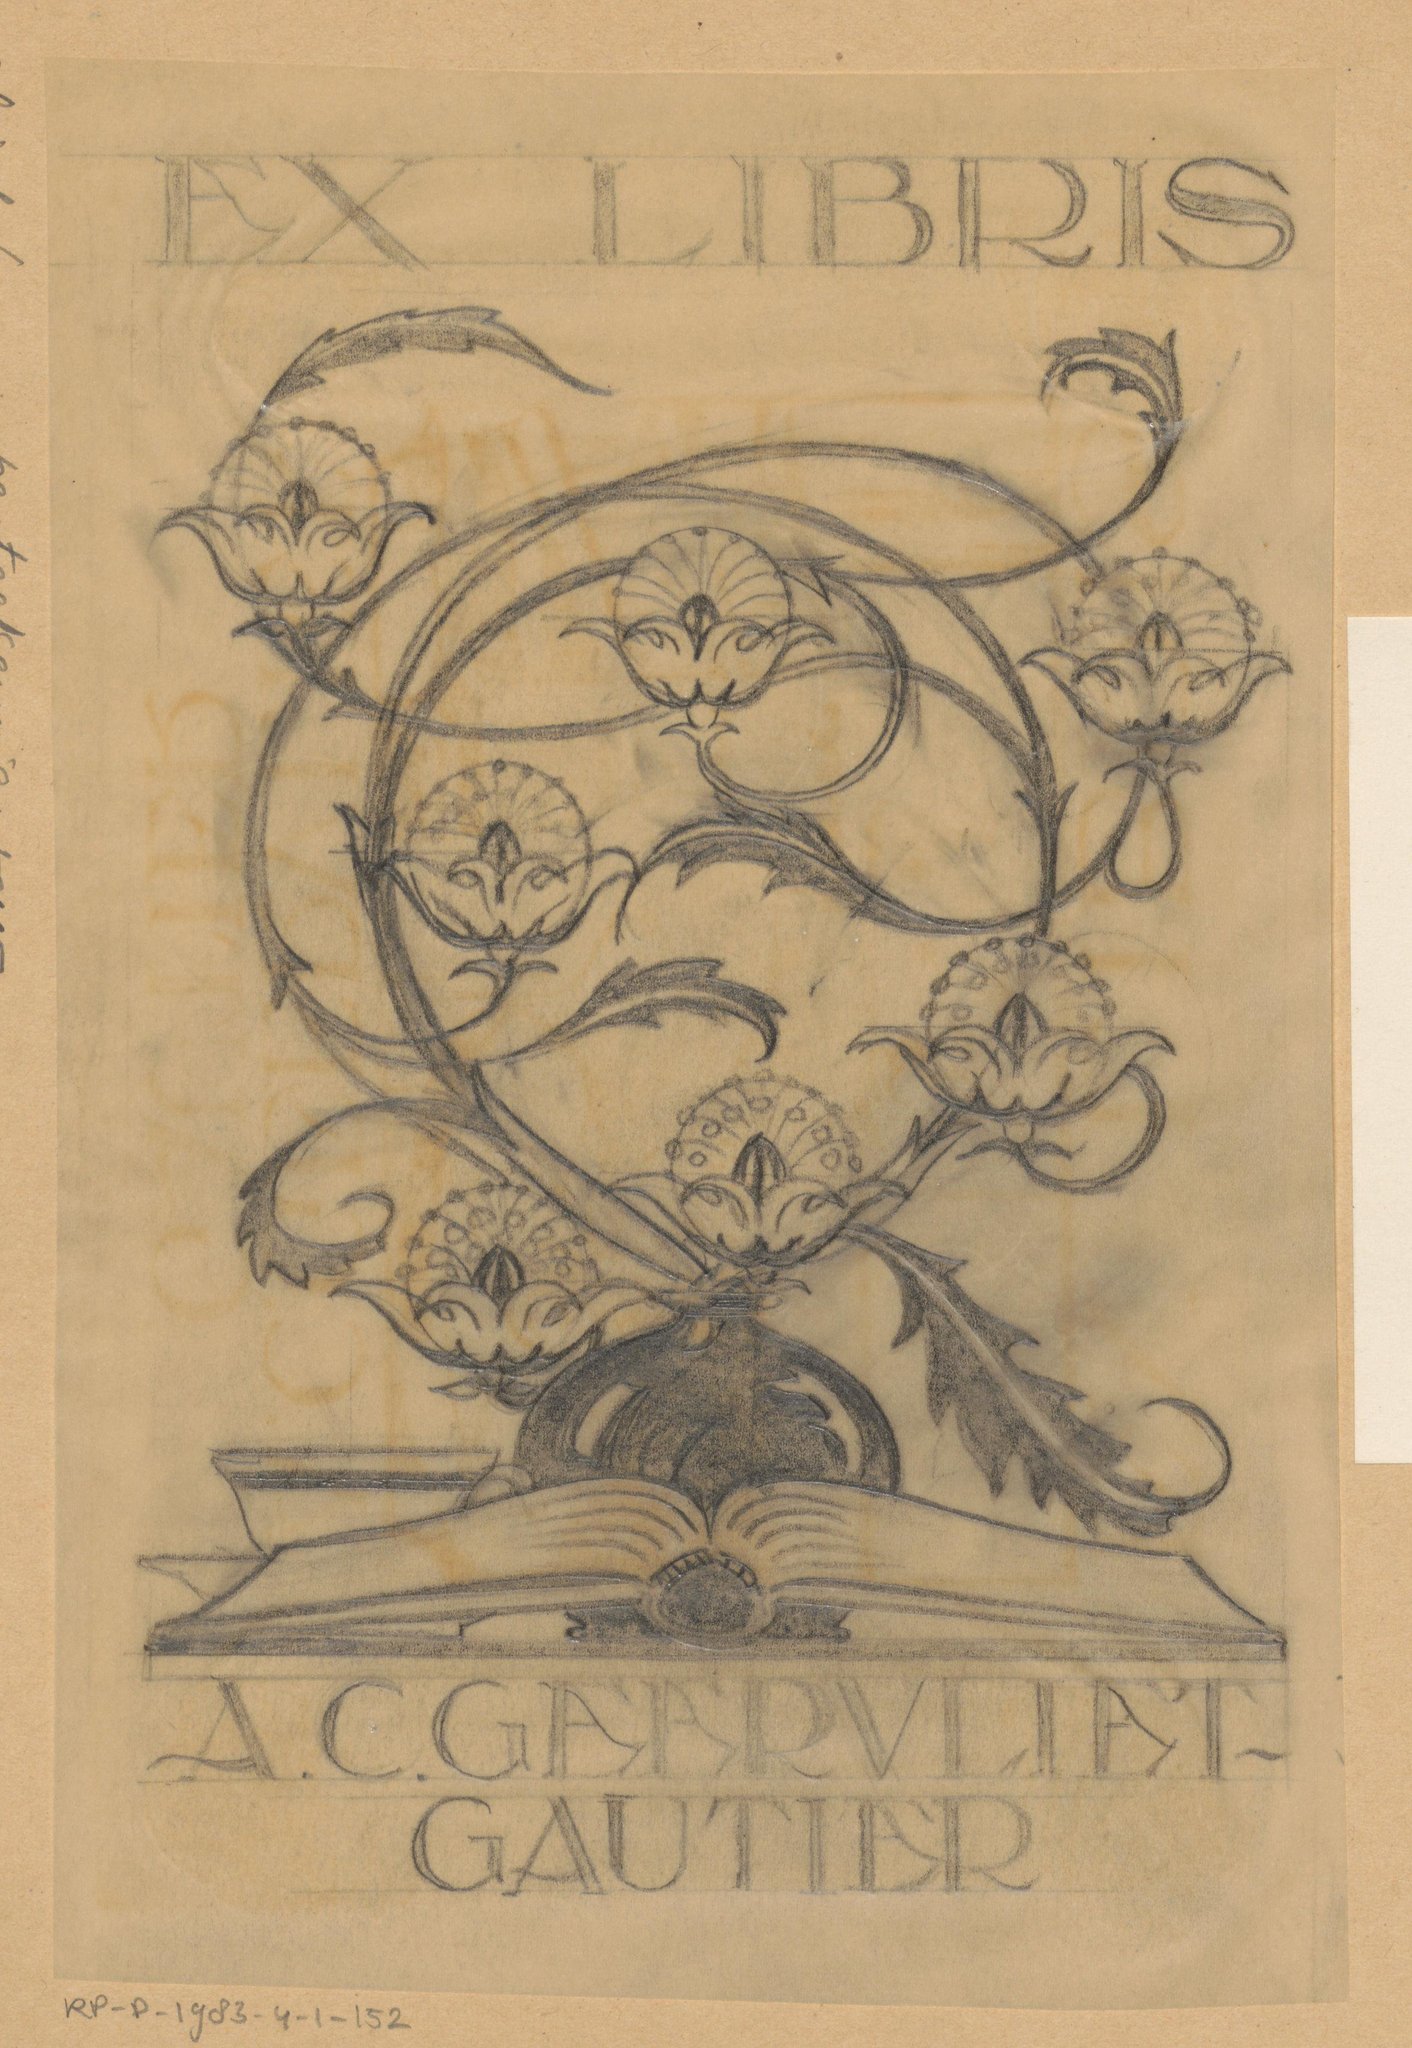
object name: design drawing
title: Ontwerptekening voor ex libris van A.C. Geervliet-Gautier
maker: otto verhagen (i)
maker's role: draughtsman, print maker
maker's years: 1885-1951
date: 1945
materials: paper, pencil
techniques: drawing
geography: netherlands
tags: cut flowers; nosegay, bunch of flowers, book, flowers in a vase